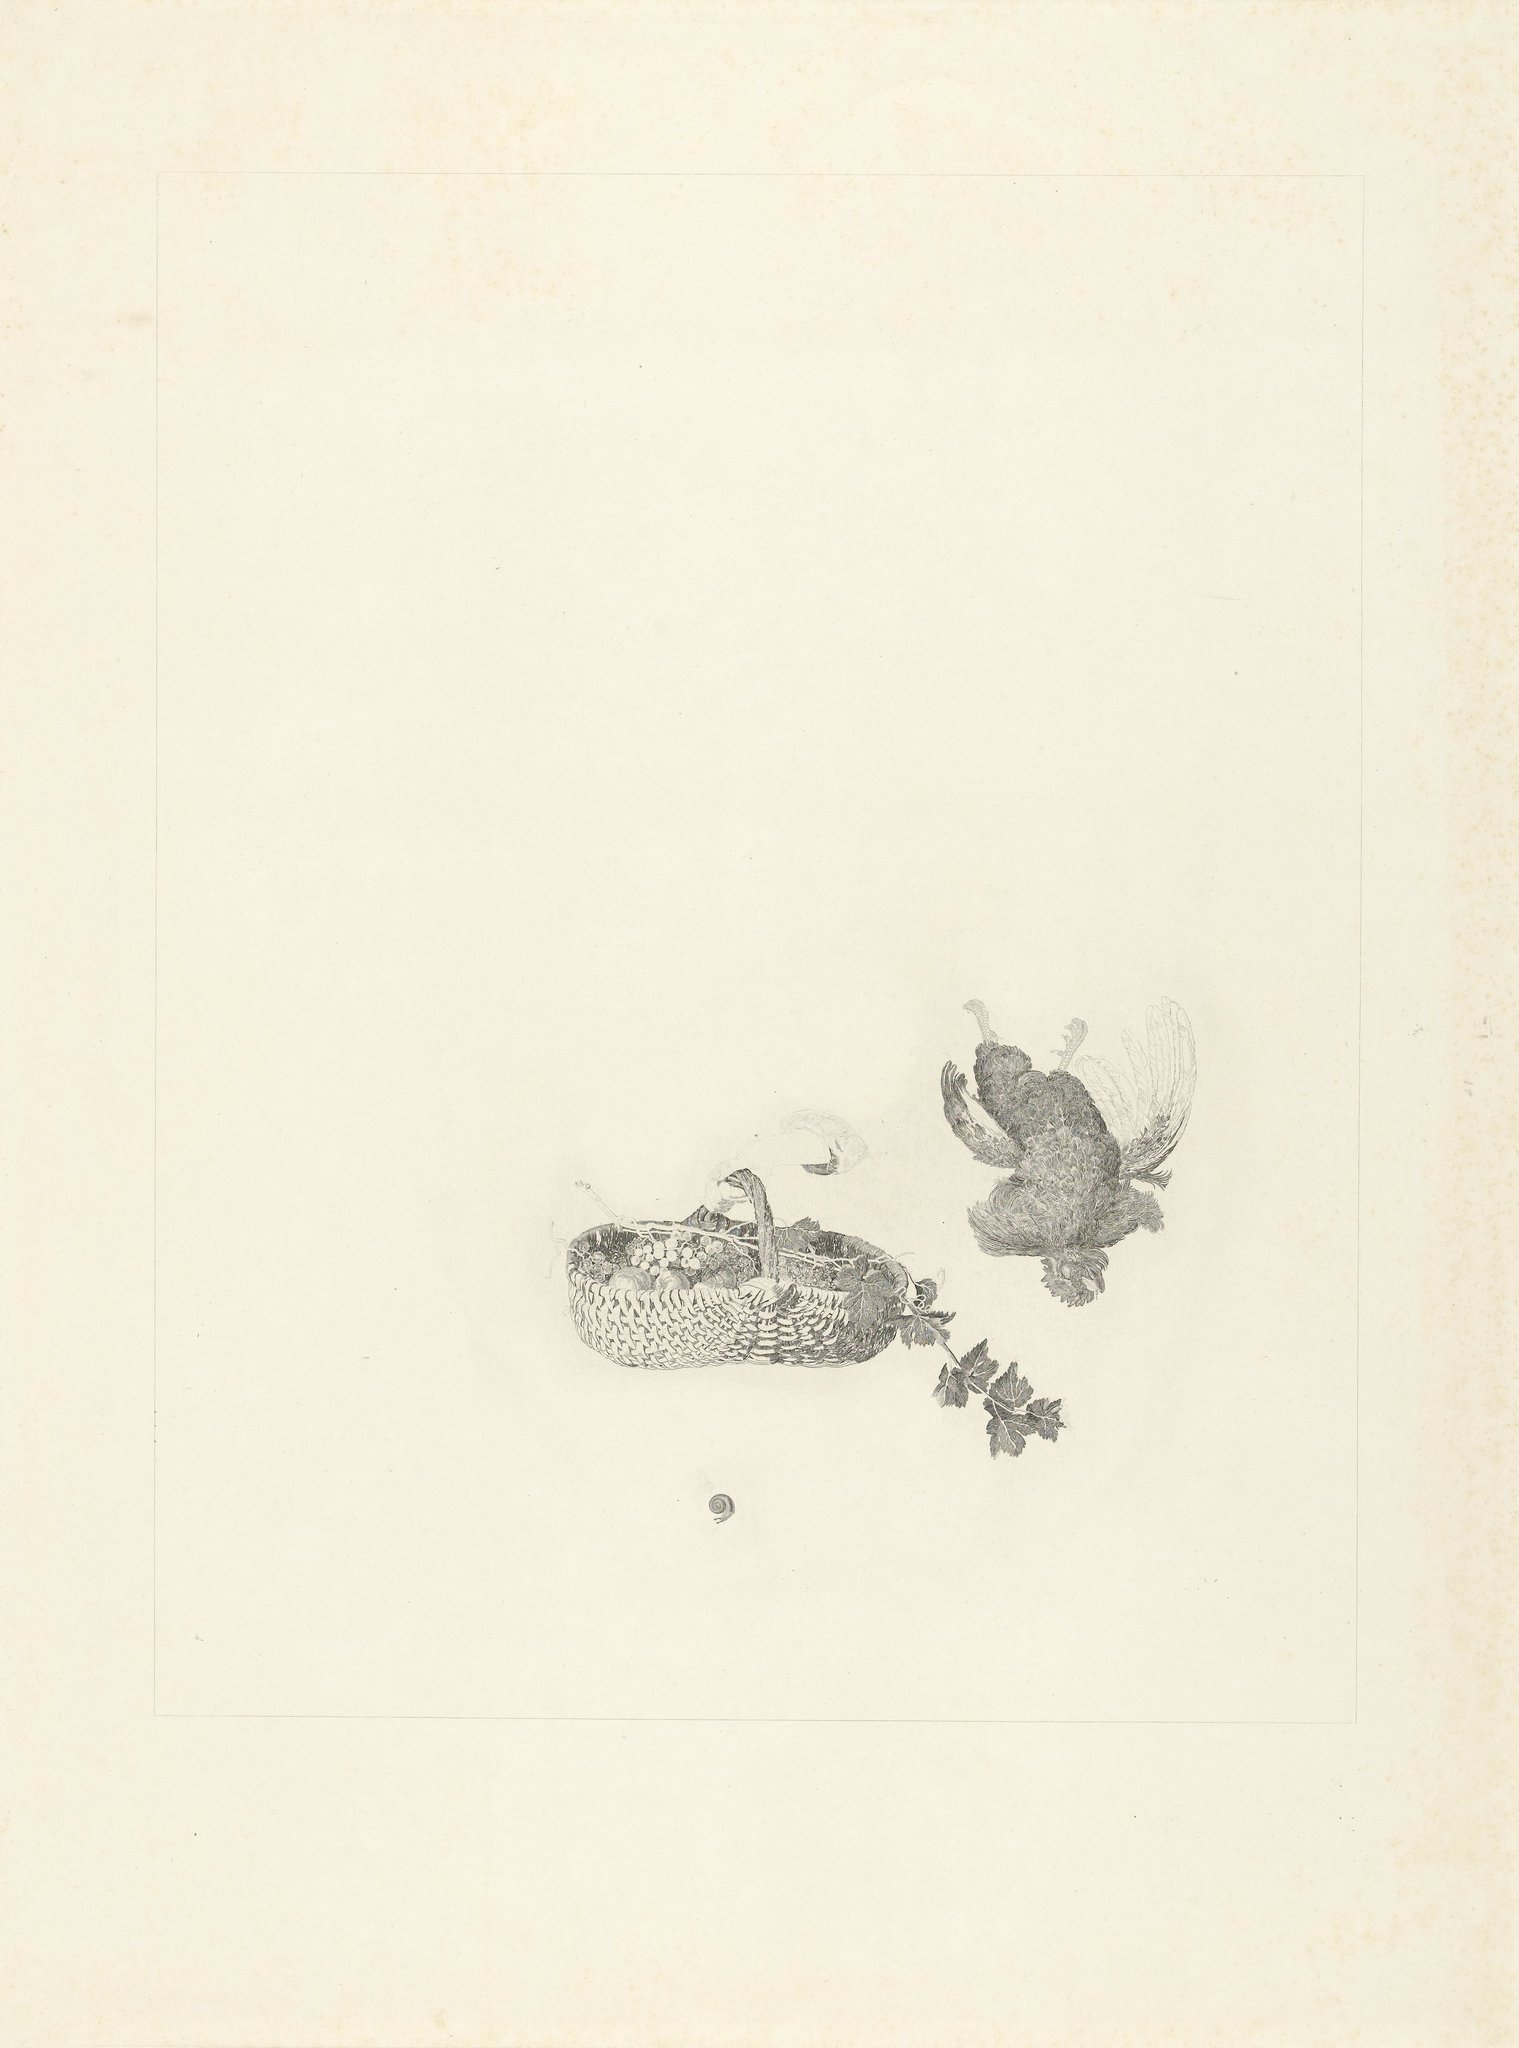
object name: print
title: Vrouw met mand met vruchten in de hand bij het raam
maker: henricus wilhelmus couwenberg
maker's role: draughtsman, print maker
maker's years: 1814-1845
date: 1840-1842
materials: paper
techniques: etching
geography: amsterdam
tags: human figure at (open) window, seen from outside, shop-window, show-window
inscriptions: collector's mark: Lugt 2228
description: Staat 1 tot 15 door Henricus Wilhelmus Couwenberg, staat 15 tot 24 door Johannes de Mare en staat 24 en 25 door Johann Wilhelm Kaiser.